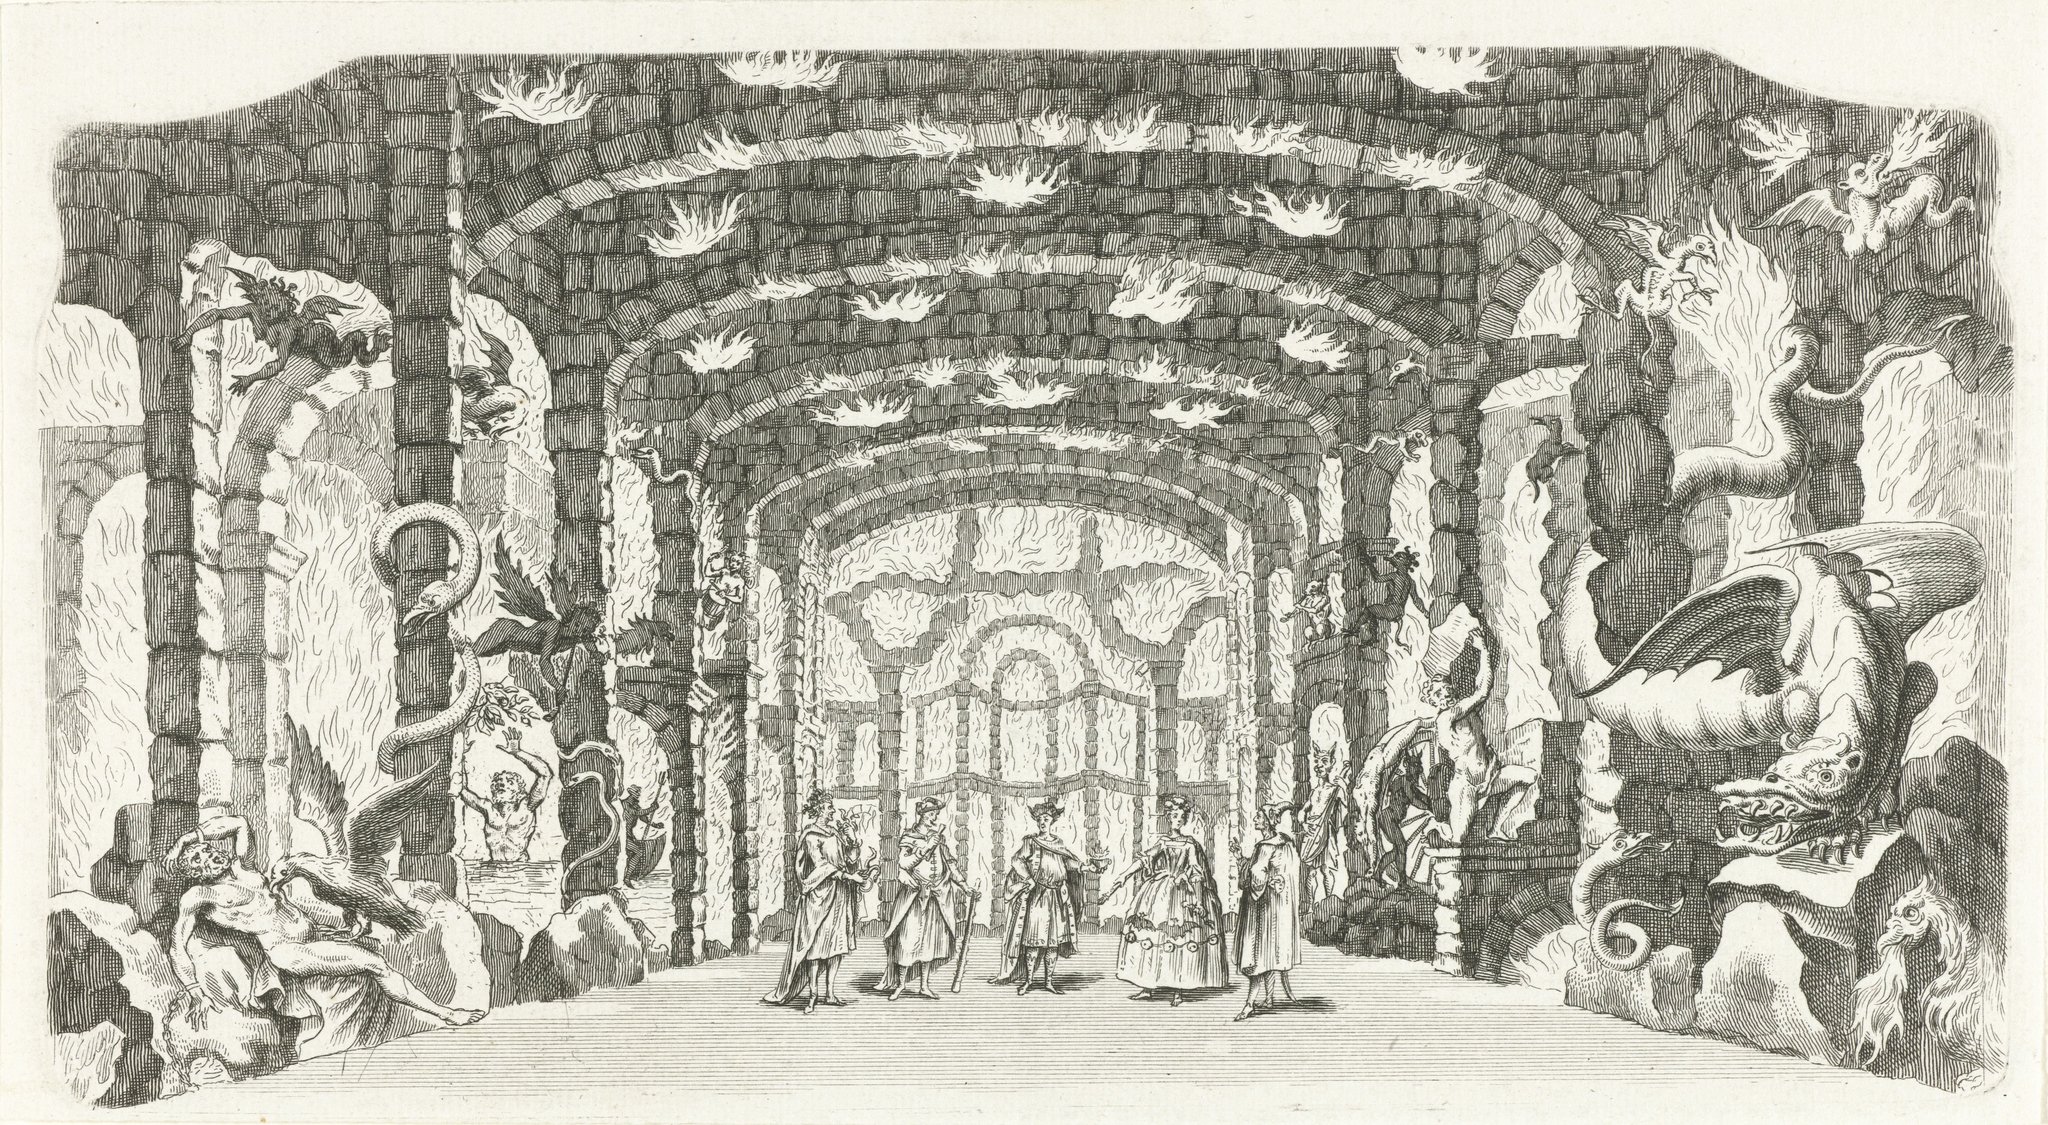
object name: print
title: Toneeldecors van de Amsterdamse Schouwburg, ca. 1760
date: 1738-1740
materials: paper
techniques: engraving, etching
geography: amsterdam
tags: theatre, theatrical performance, stage design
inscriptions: collector's mark: Lugt 2228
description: Scènes uit het toneelstuk "Het Eeuwgetijde van den Amsteldamschen Schouwburg" door Jan de Marre, Amsterdam 1738. Deze platen zijn in verschillende groepen in verschillende periodes vervaardigd tussen 1738-1760 en uitgegeven in verschillende series ca. 1760 en ca. 1770-1772. De platen zijn door Muller ingedeeld bij de platen van de brand van de Amsterdamse Schouwburg in 1772.